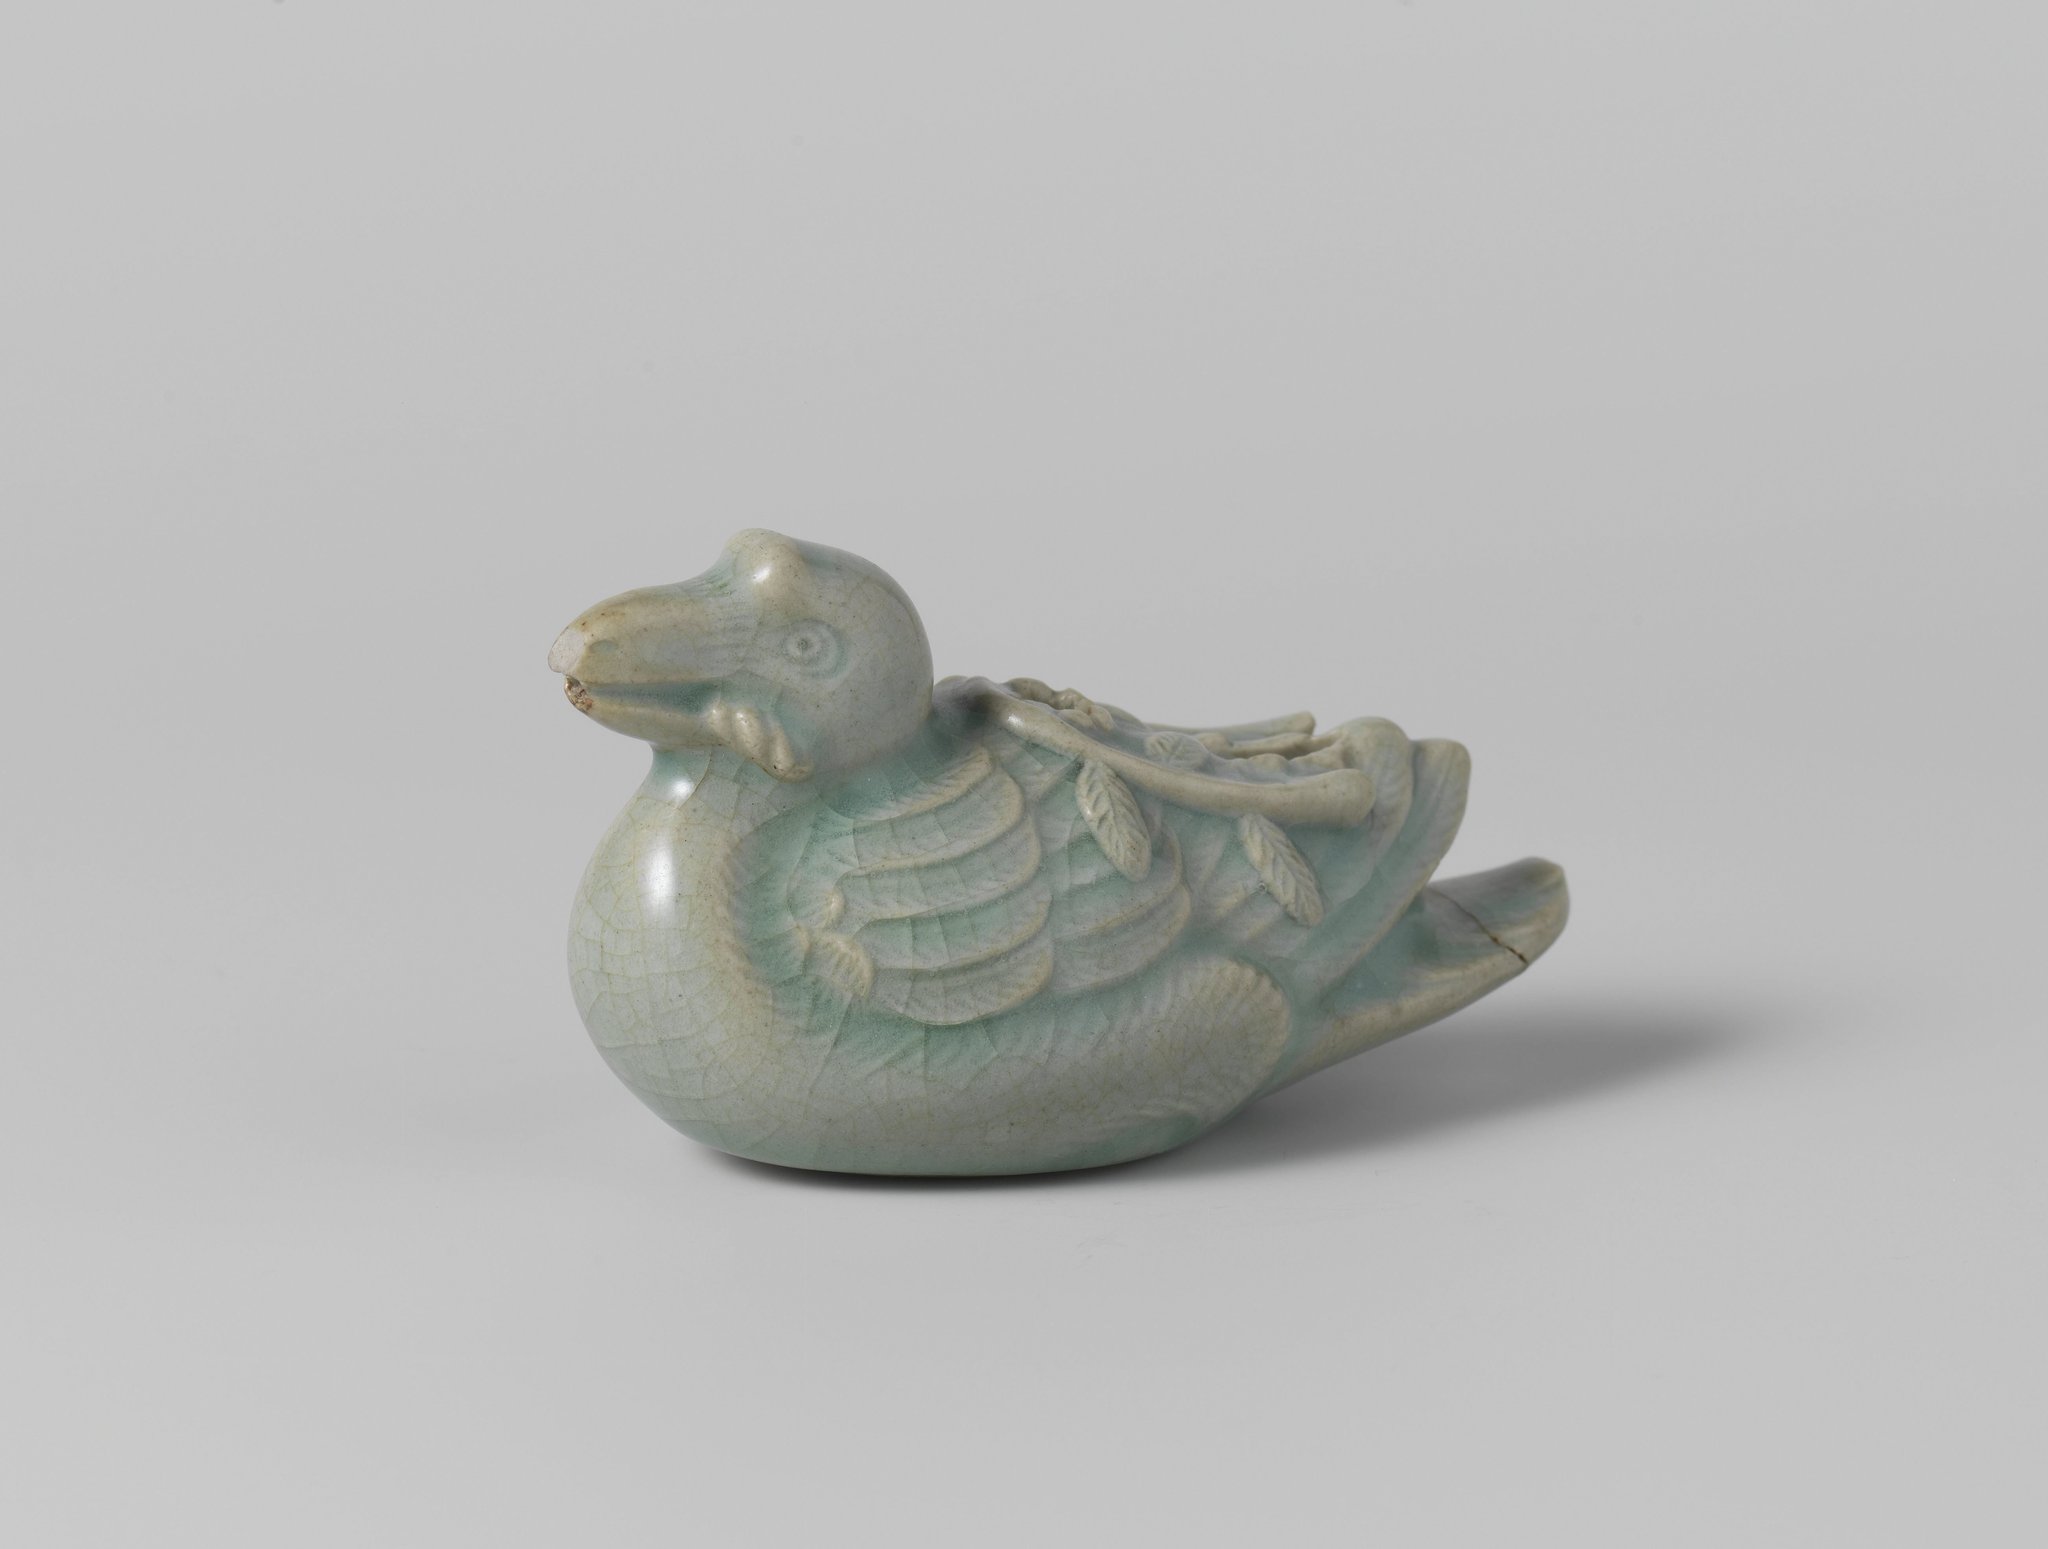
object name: water dropper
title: Water dropper in the shape of a duck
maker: Anonymous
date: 1100-1199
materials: glaze, stoneware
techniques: firing, forming, vitrification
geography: korea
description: Green glazed ceramics, known as celadon ware in the West, were highly appreciated in East Asia. By the 12th century Korean potters were able to create unique vessels perfectly combining natural simplicity and refined elegance. For instance, despite the stylisation, the duck’s natural character has been retained in this sprinkler.